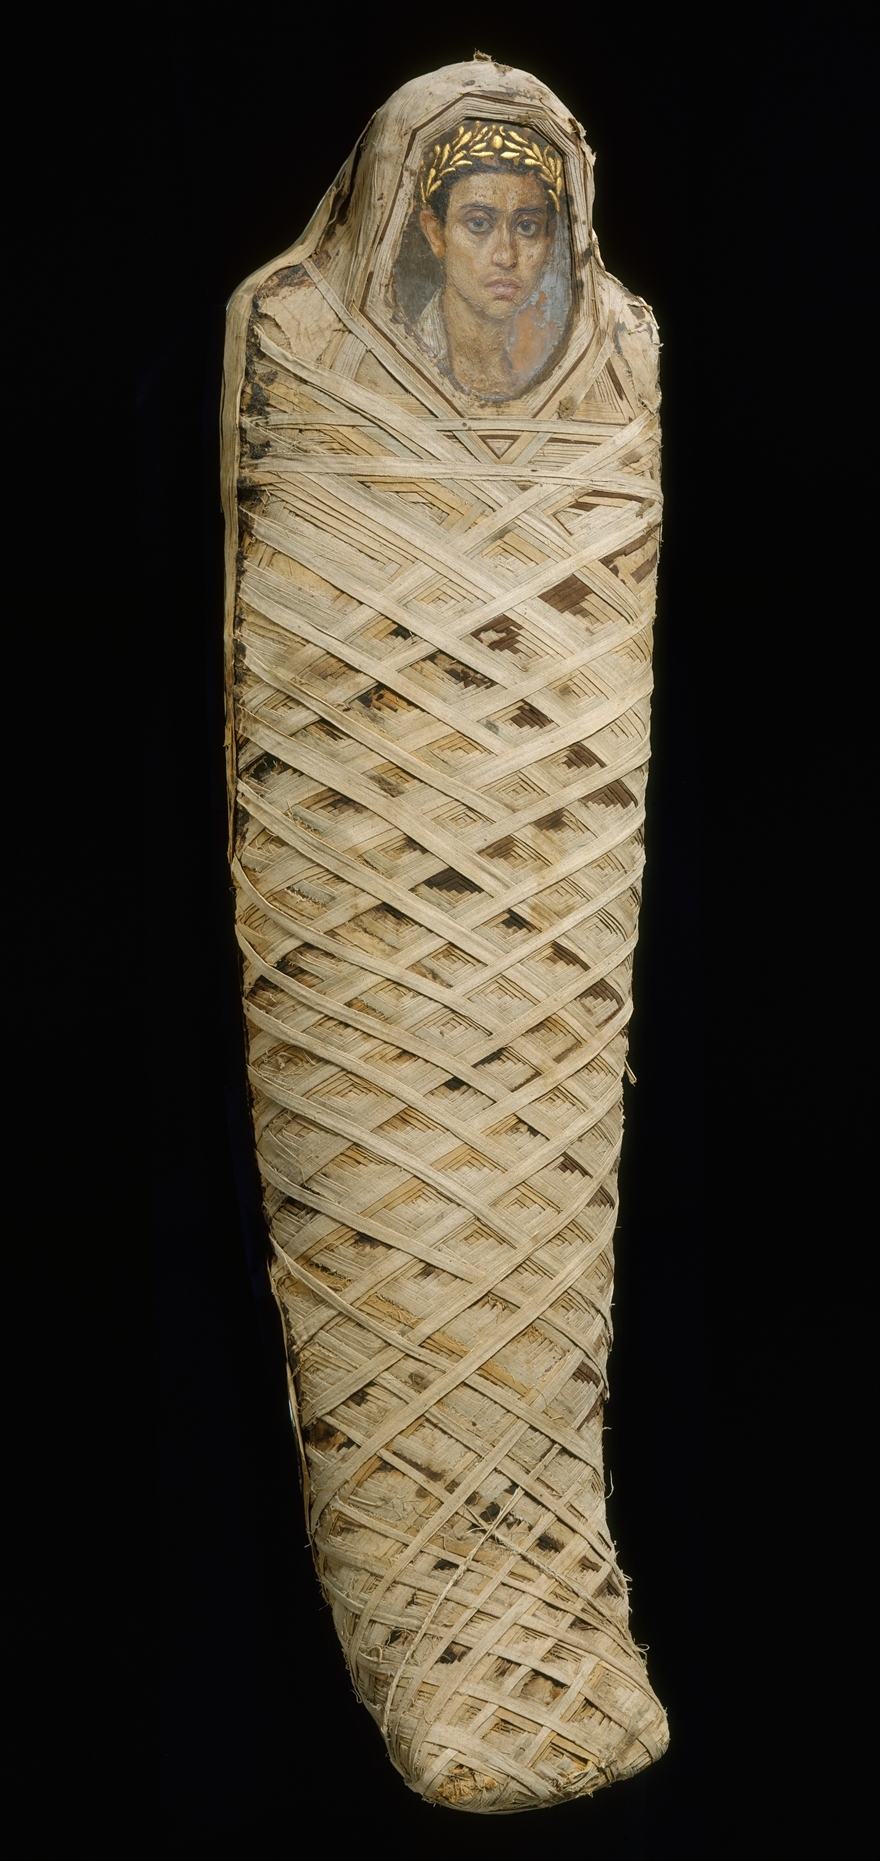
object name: mummy, youth, panel portrait, human remains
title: Mummy with an Inserted Panel Portrait of a Youth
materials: linen, panel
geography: egypt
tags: men,portraits